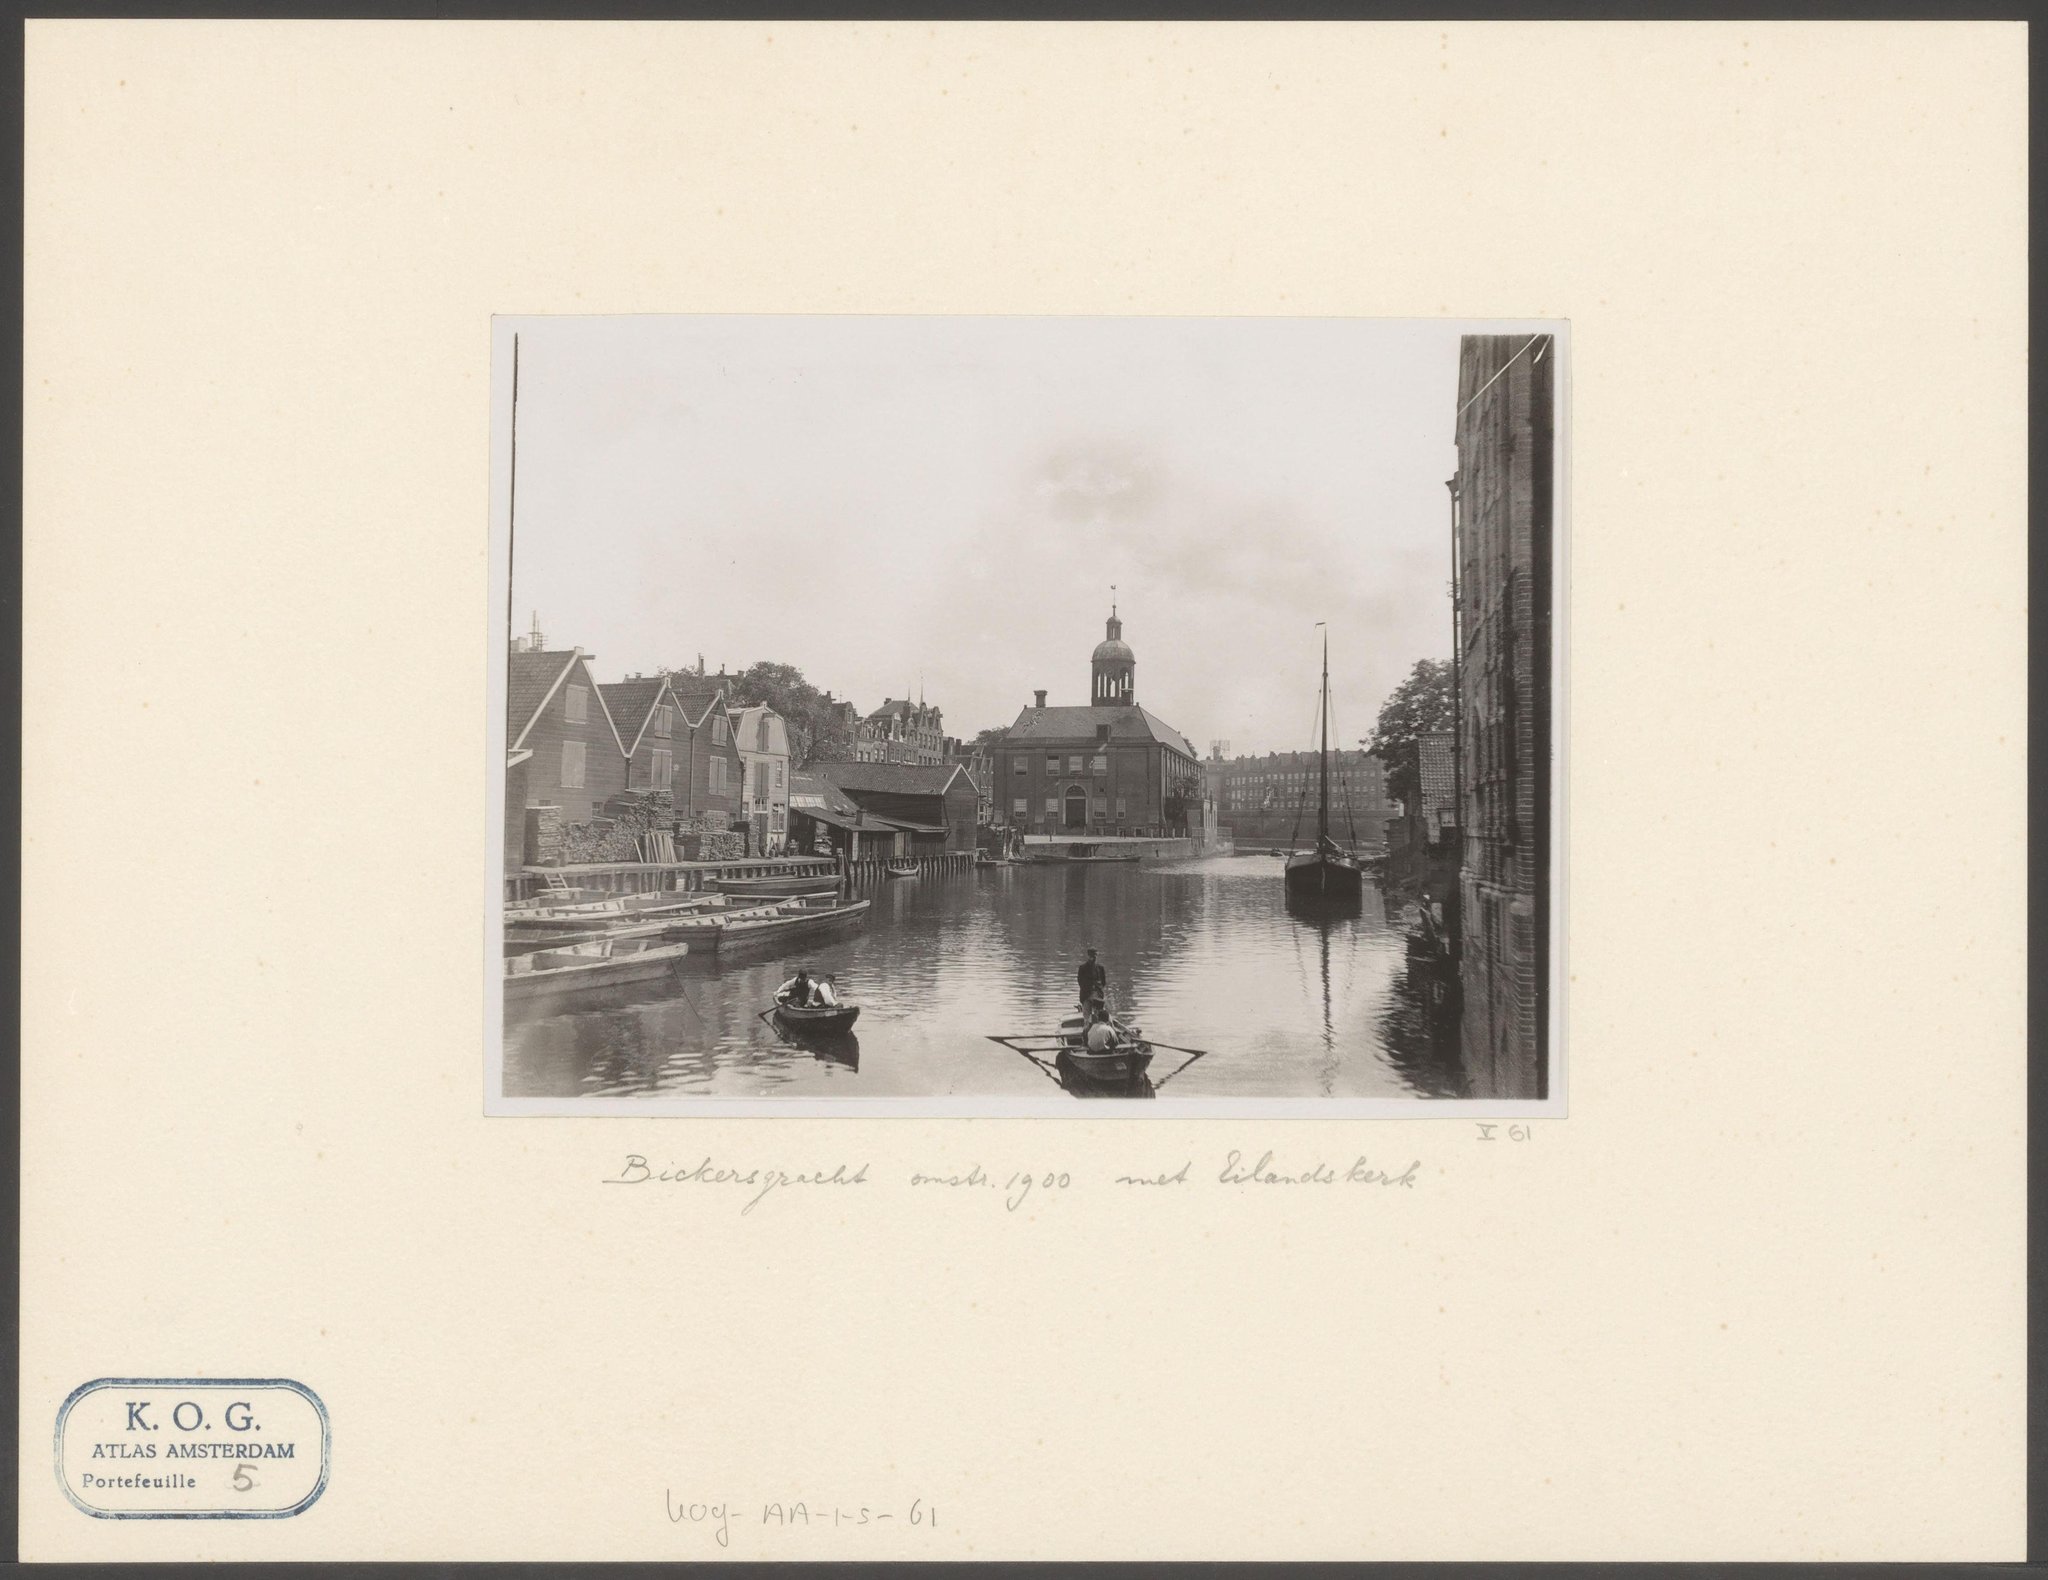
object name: photograph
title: Gezicht op de Bickersgracht en de Eilandskerk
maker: Anonymous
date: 1900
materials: paper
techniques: gelatin silver print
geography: amsterdam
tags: city-view in general; 'veduta', canal, church (exterior)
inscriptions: collector's mark: ‘5’ Lugt 1641b, inscription: ‘Bickersgracht omstr. 1900 met Eilandskerk’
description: Onderwerpsrubriek binnen de Atlas Amsterdam: Begijnensloot (Gedempte), Bagijnhofsteeg, Beulingsloot, Bickersgracht en –plein, Bickersstraat (Groote), Bilderdijkskade en -straat, Binnenkant, Blauwburgwal, Boomdwarsstraat, Brouwersgracht, Bleekersspad (Lange), Bleekerssloot, Bloemgracht, Boerenwetering, Boltensgrachtje, Boomssloot (Recht), Badhuisweg.